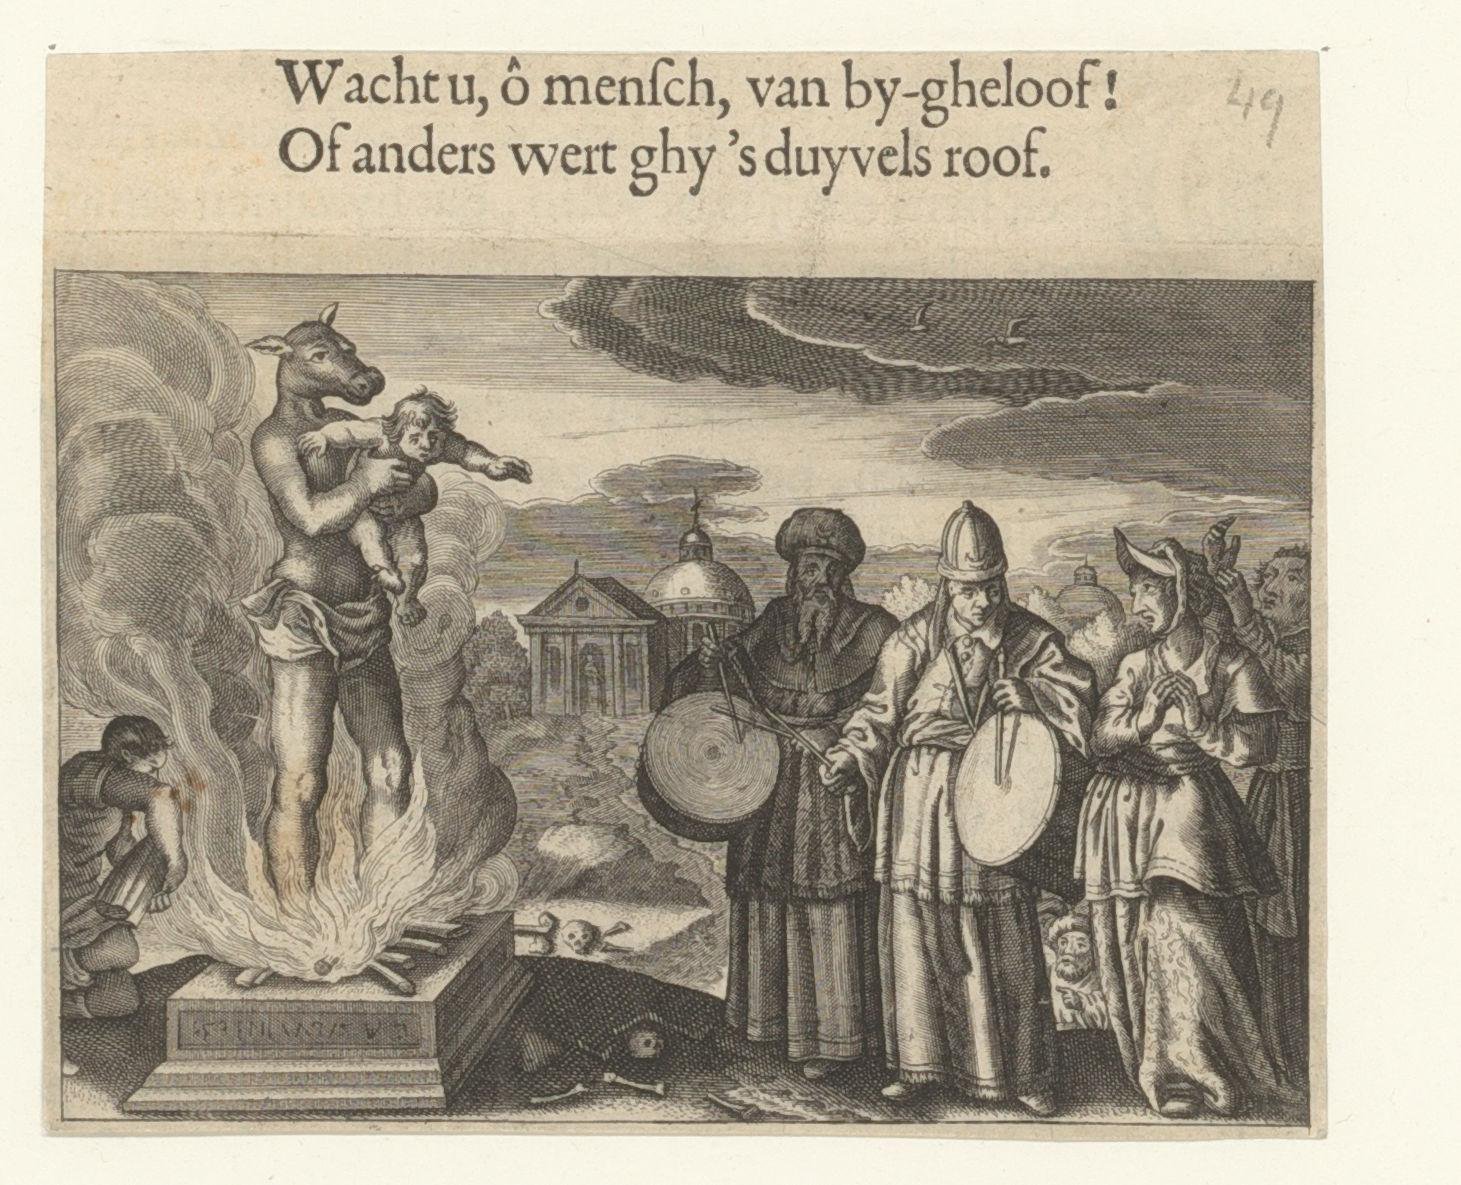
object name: book illustration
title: Wacht u, ô mensch, van by-gheloof! Of anders wert ghy's duyvels roof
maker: Anonymous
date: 1624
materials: paper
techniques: engraving, letterpress printing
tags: ritual practices ~ non-christian religions, superstition, popular belief, devil(s) and demons, toddler (male), proverbs, sayings, etc., priest ~ non-christian religions, altar ~ non-christian religions - bb - in the open air, sacrificial feast ~ non-christian religions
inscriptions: stamp, collector's mark: Lugt 1641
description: Prent uit: Brune, Johan de. Zinne-werck, Voor-ghesyelt in Beelden, Ghedichten, ende breeder uyt-legginghen (...). Amsterdam: Evertsen Kloppenburch, 1624. Prent ook gebruikt in latere edities (1636 en 1661).